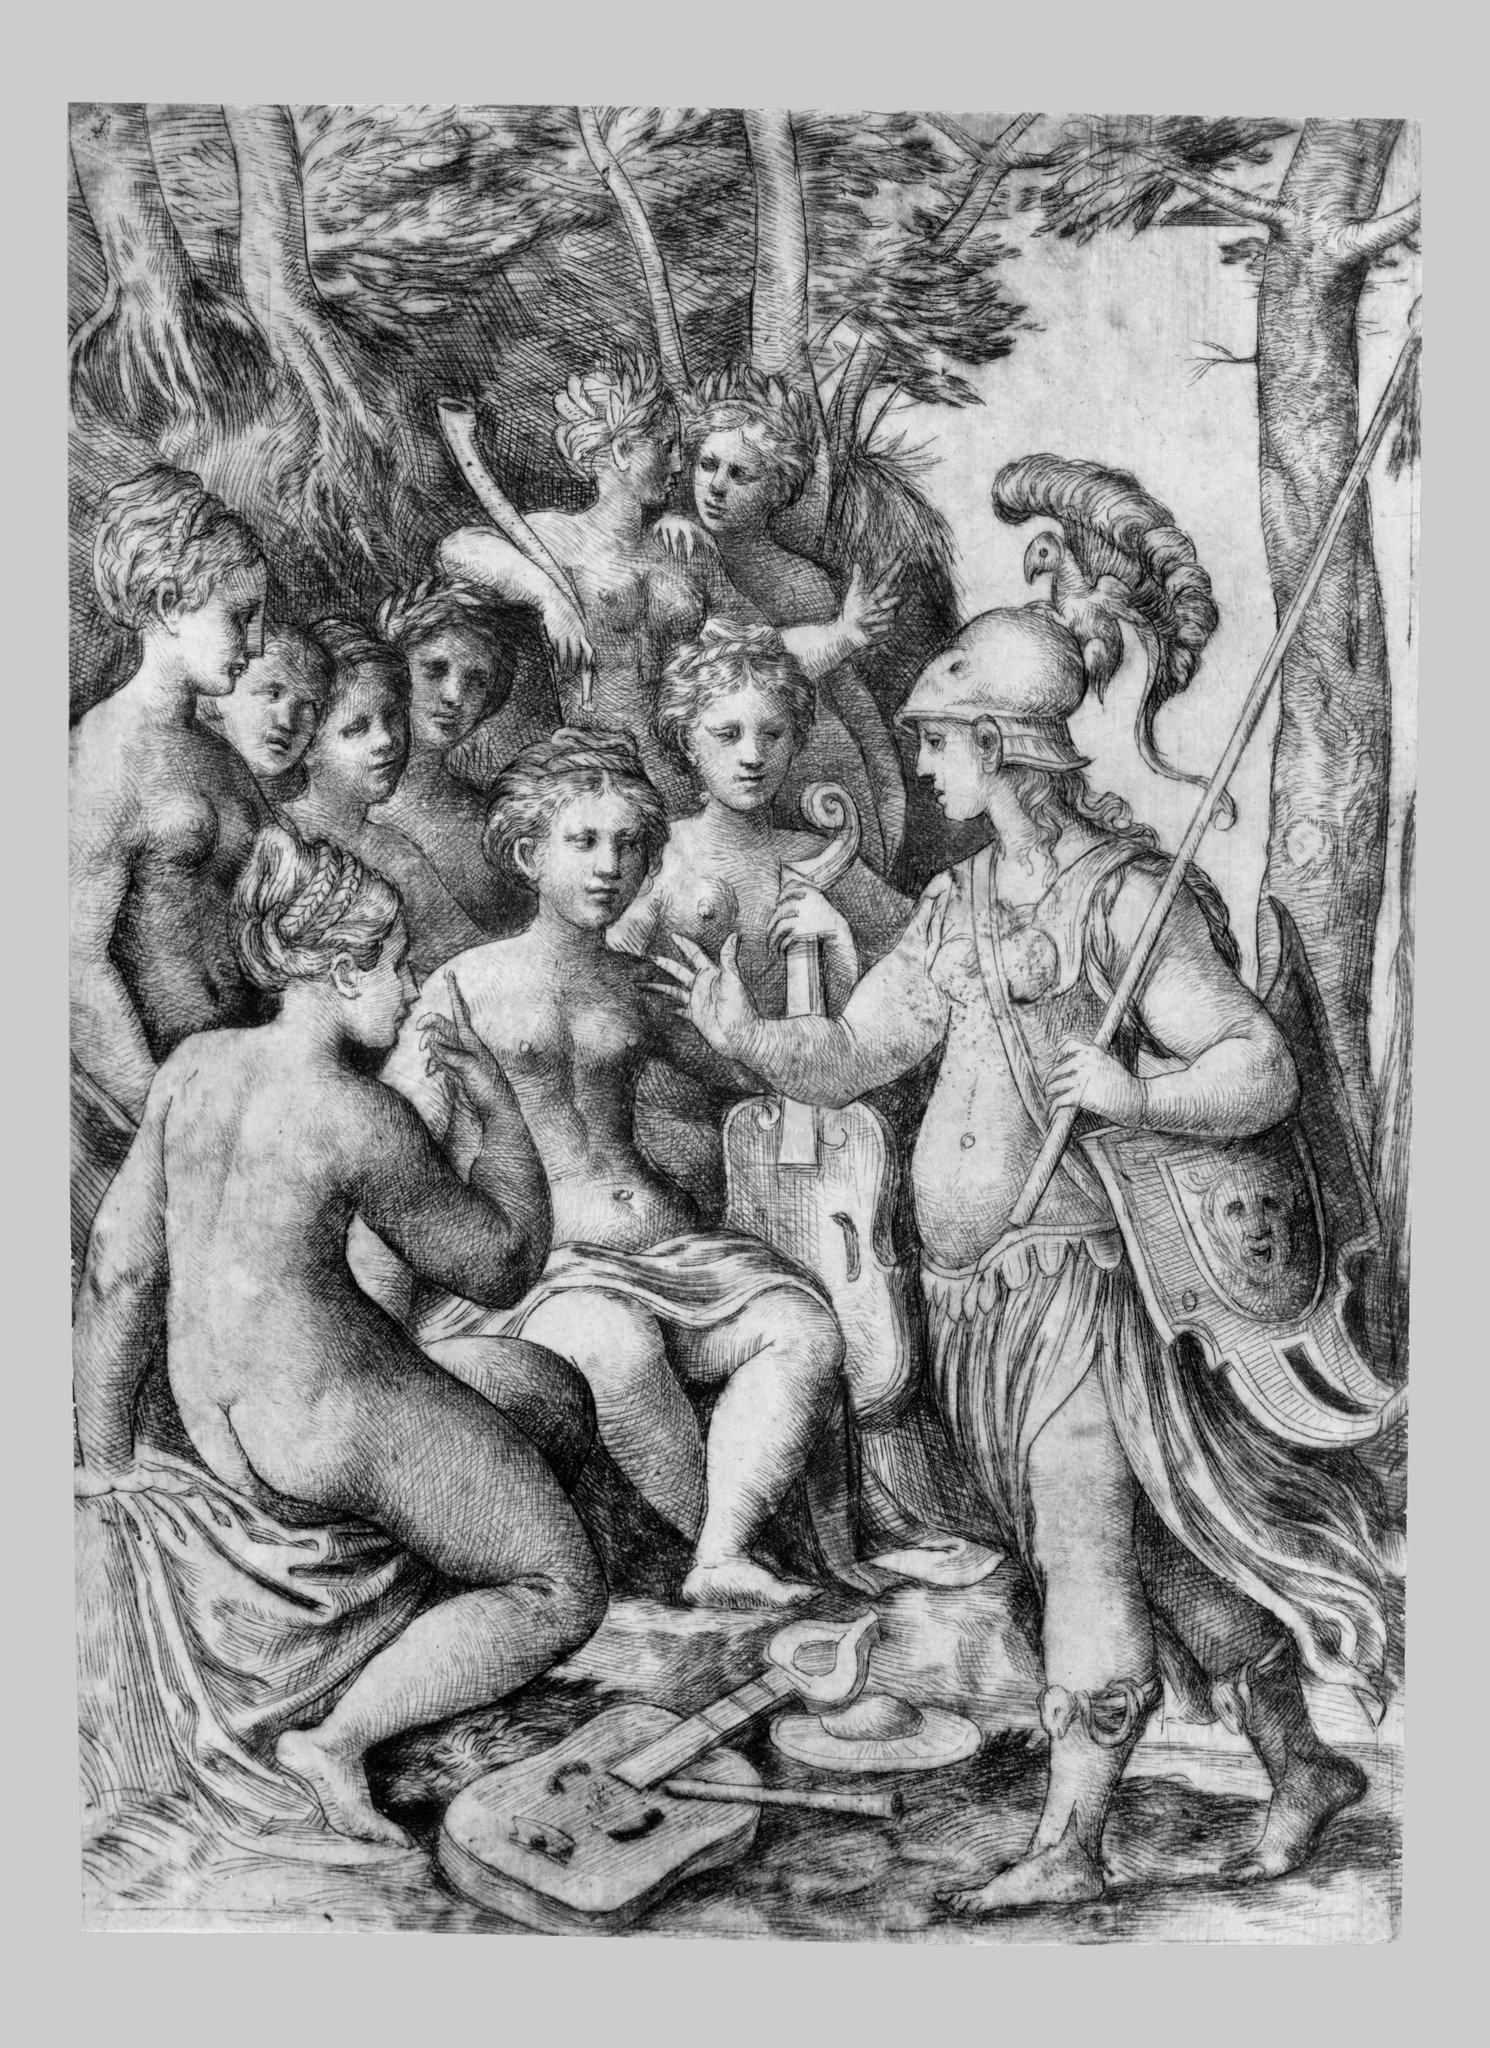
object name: print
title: Minerva and the Muses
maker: andrea schiavone (andrea meldola)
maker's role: former attribution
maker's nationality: italian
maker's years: 1510-1563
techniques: drypoint, etching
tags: musical instruments,men,female nudes,minerva